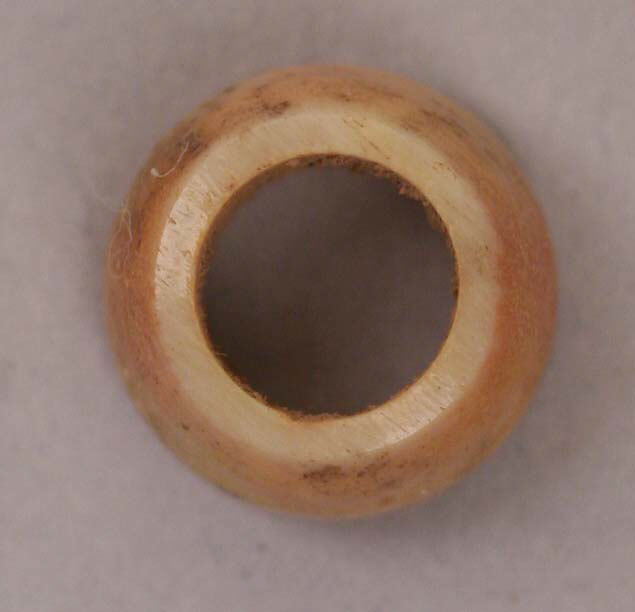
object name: button or bead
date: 801-1000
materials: bone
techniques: tinting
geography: iran